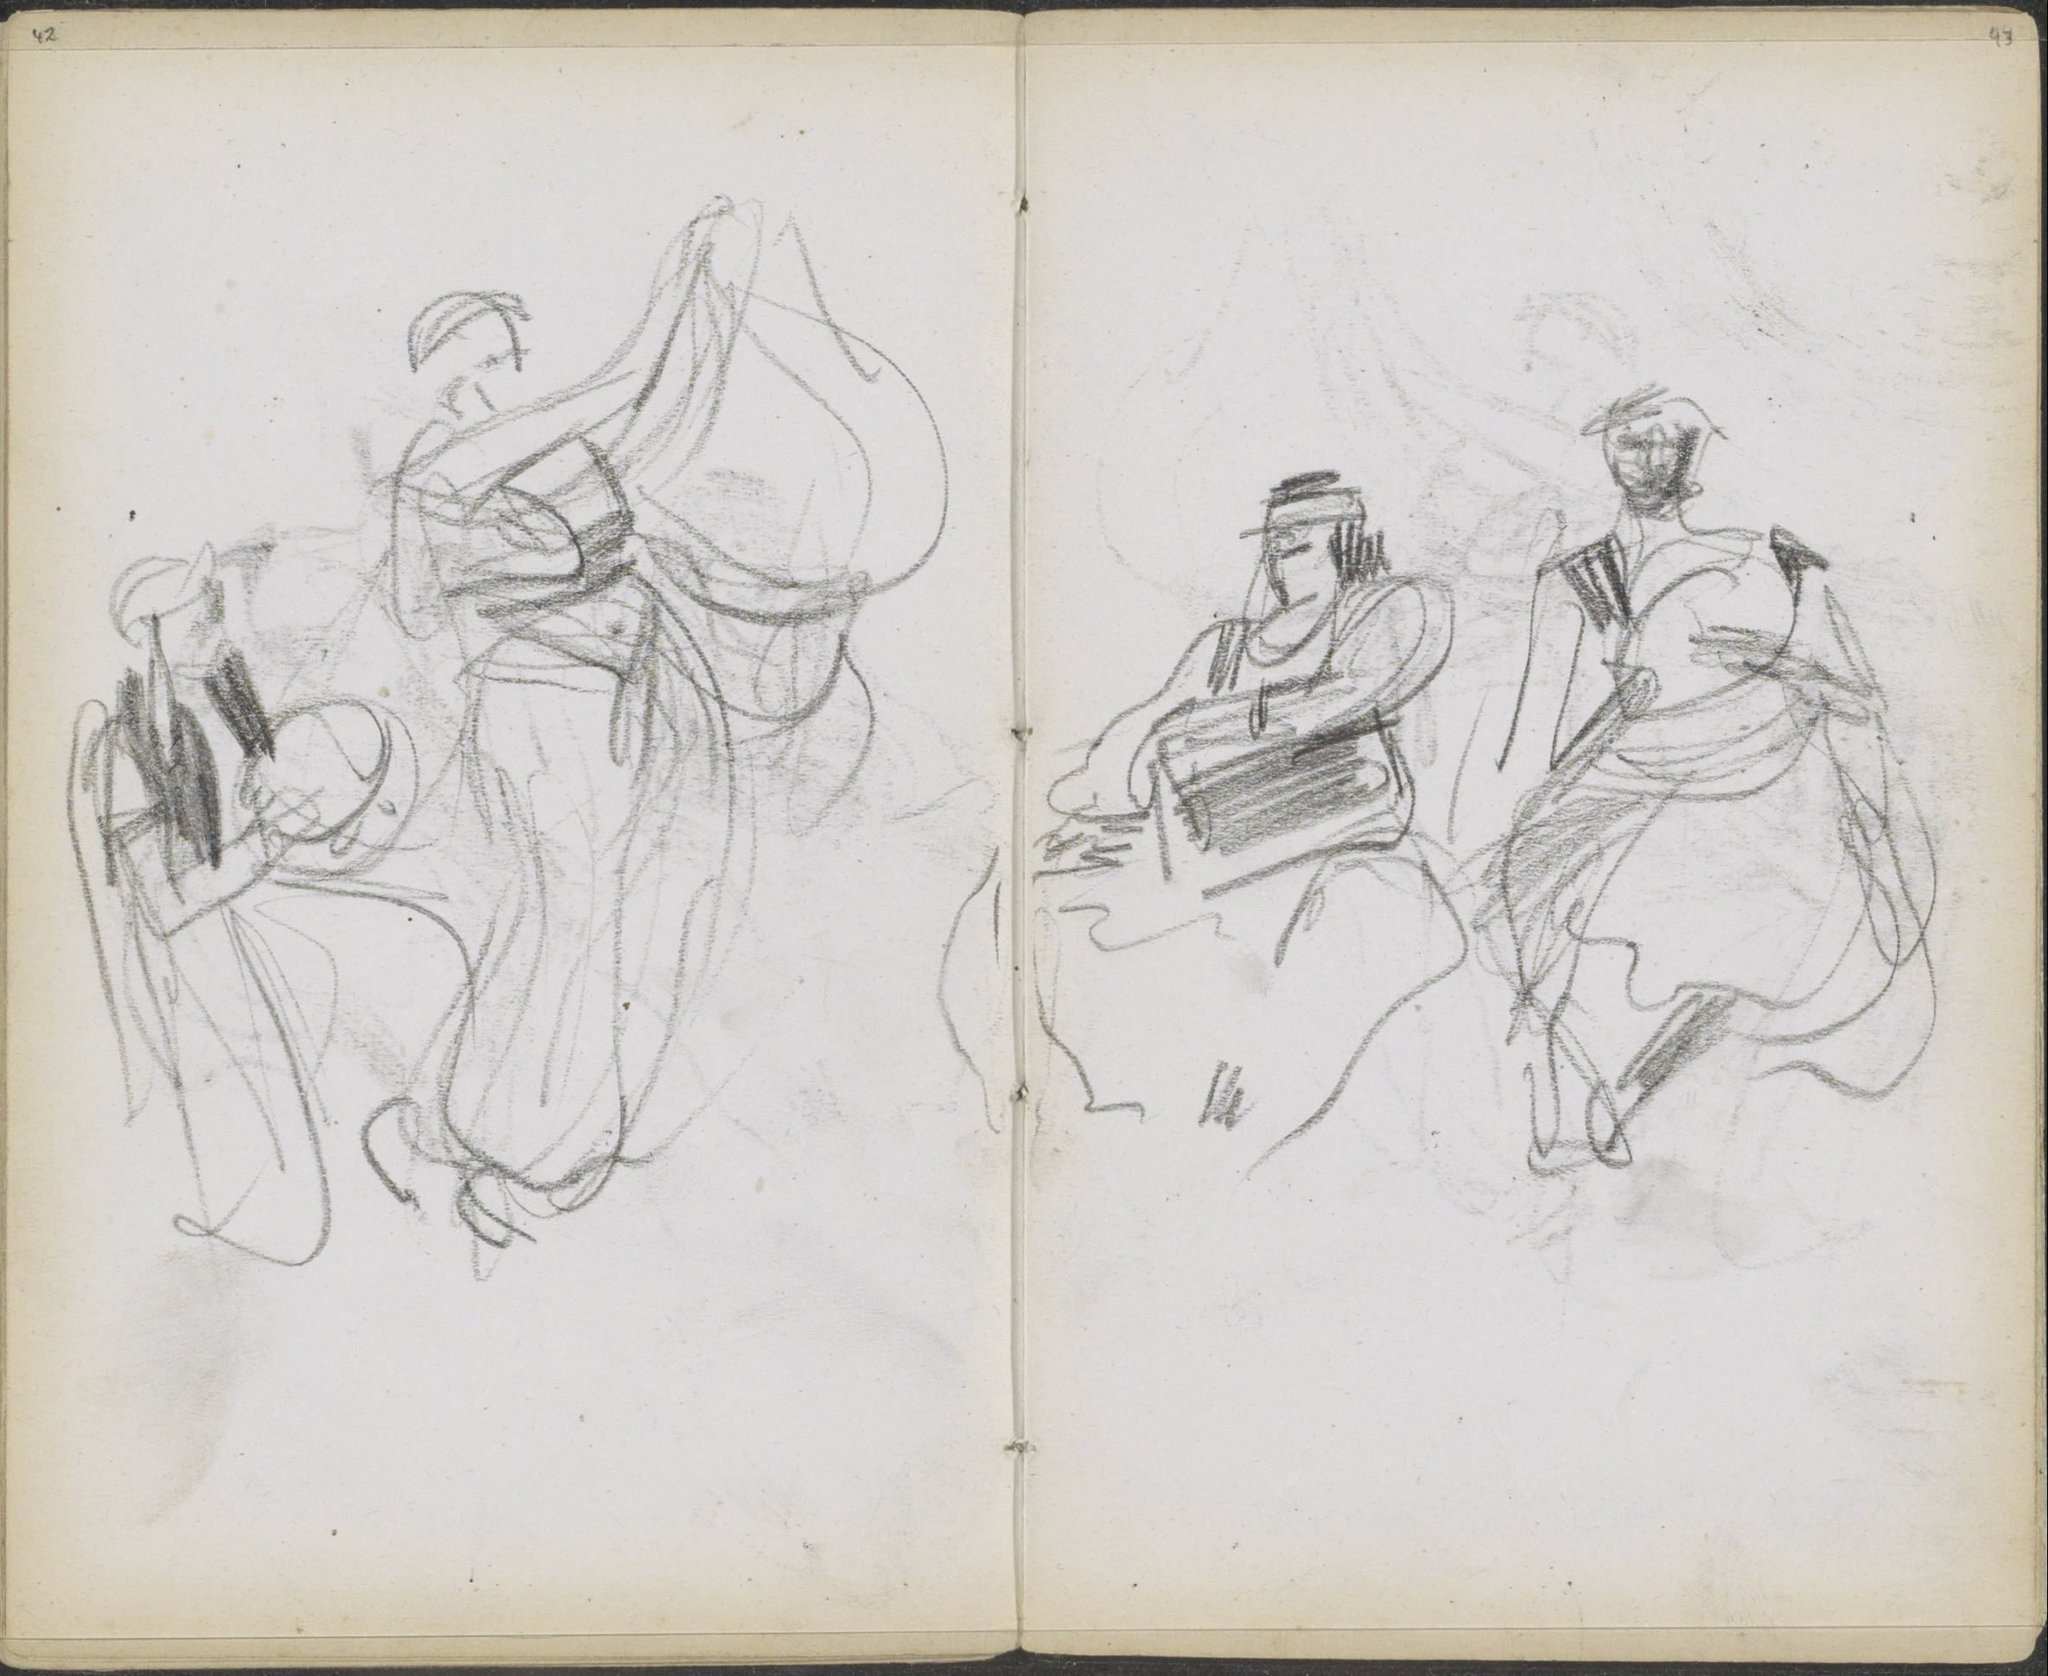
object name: sketchbook leaf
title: Buikdanseres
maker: marius bauer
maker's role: draughtsman, print maker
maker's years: 1867-1932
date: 1810-1891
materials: chalk, paper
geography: paris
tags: tambourine, female dancer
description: De danseres heeft een sjaal in haar handen. Naast haar een figuur die vermoedelijk tamboerijn speelt. Pagina 42 uit een schetsboek met 35 bladen.